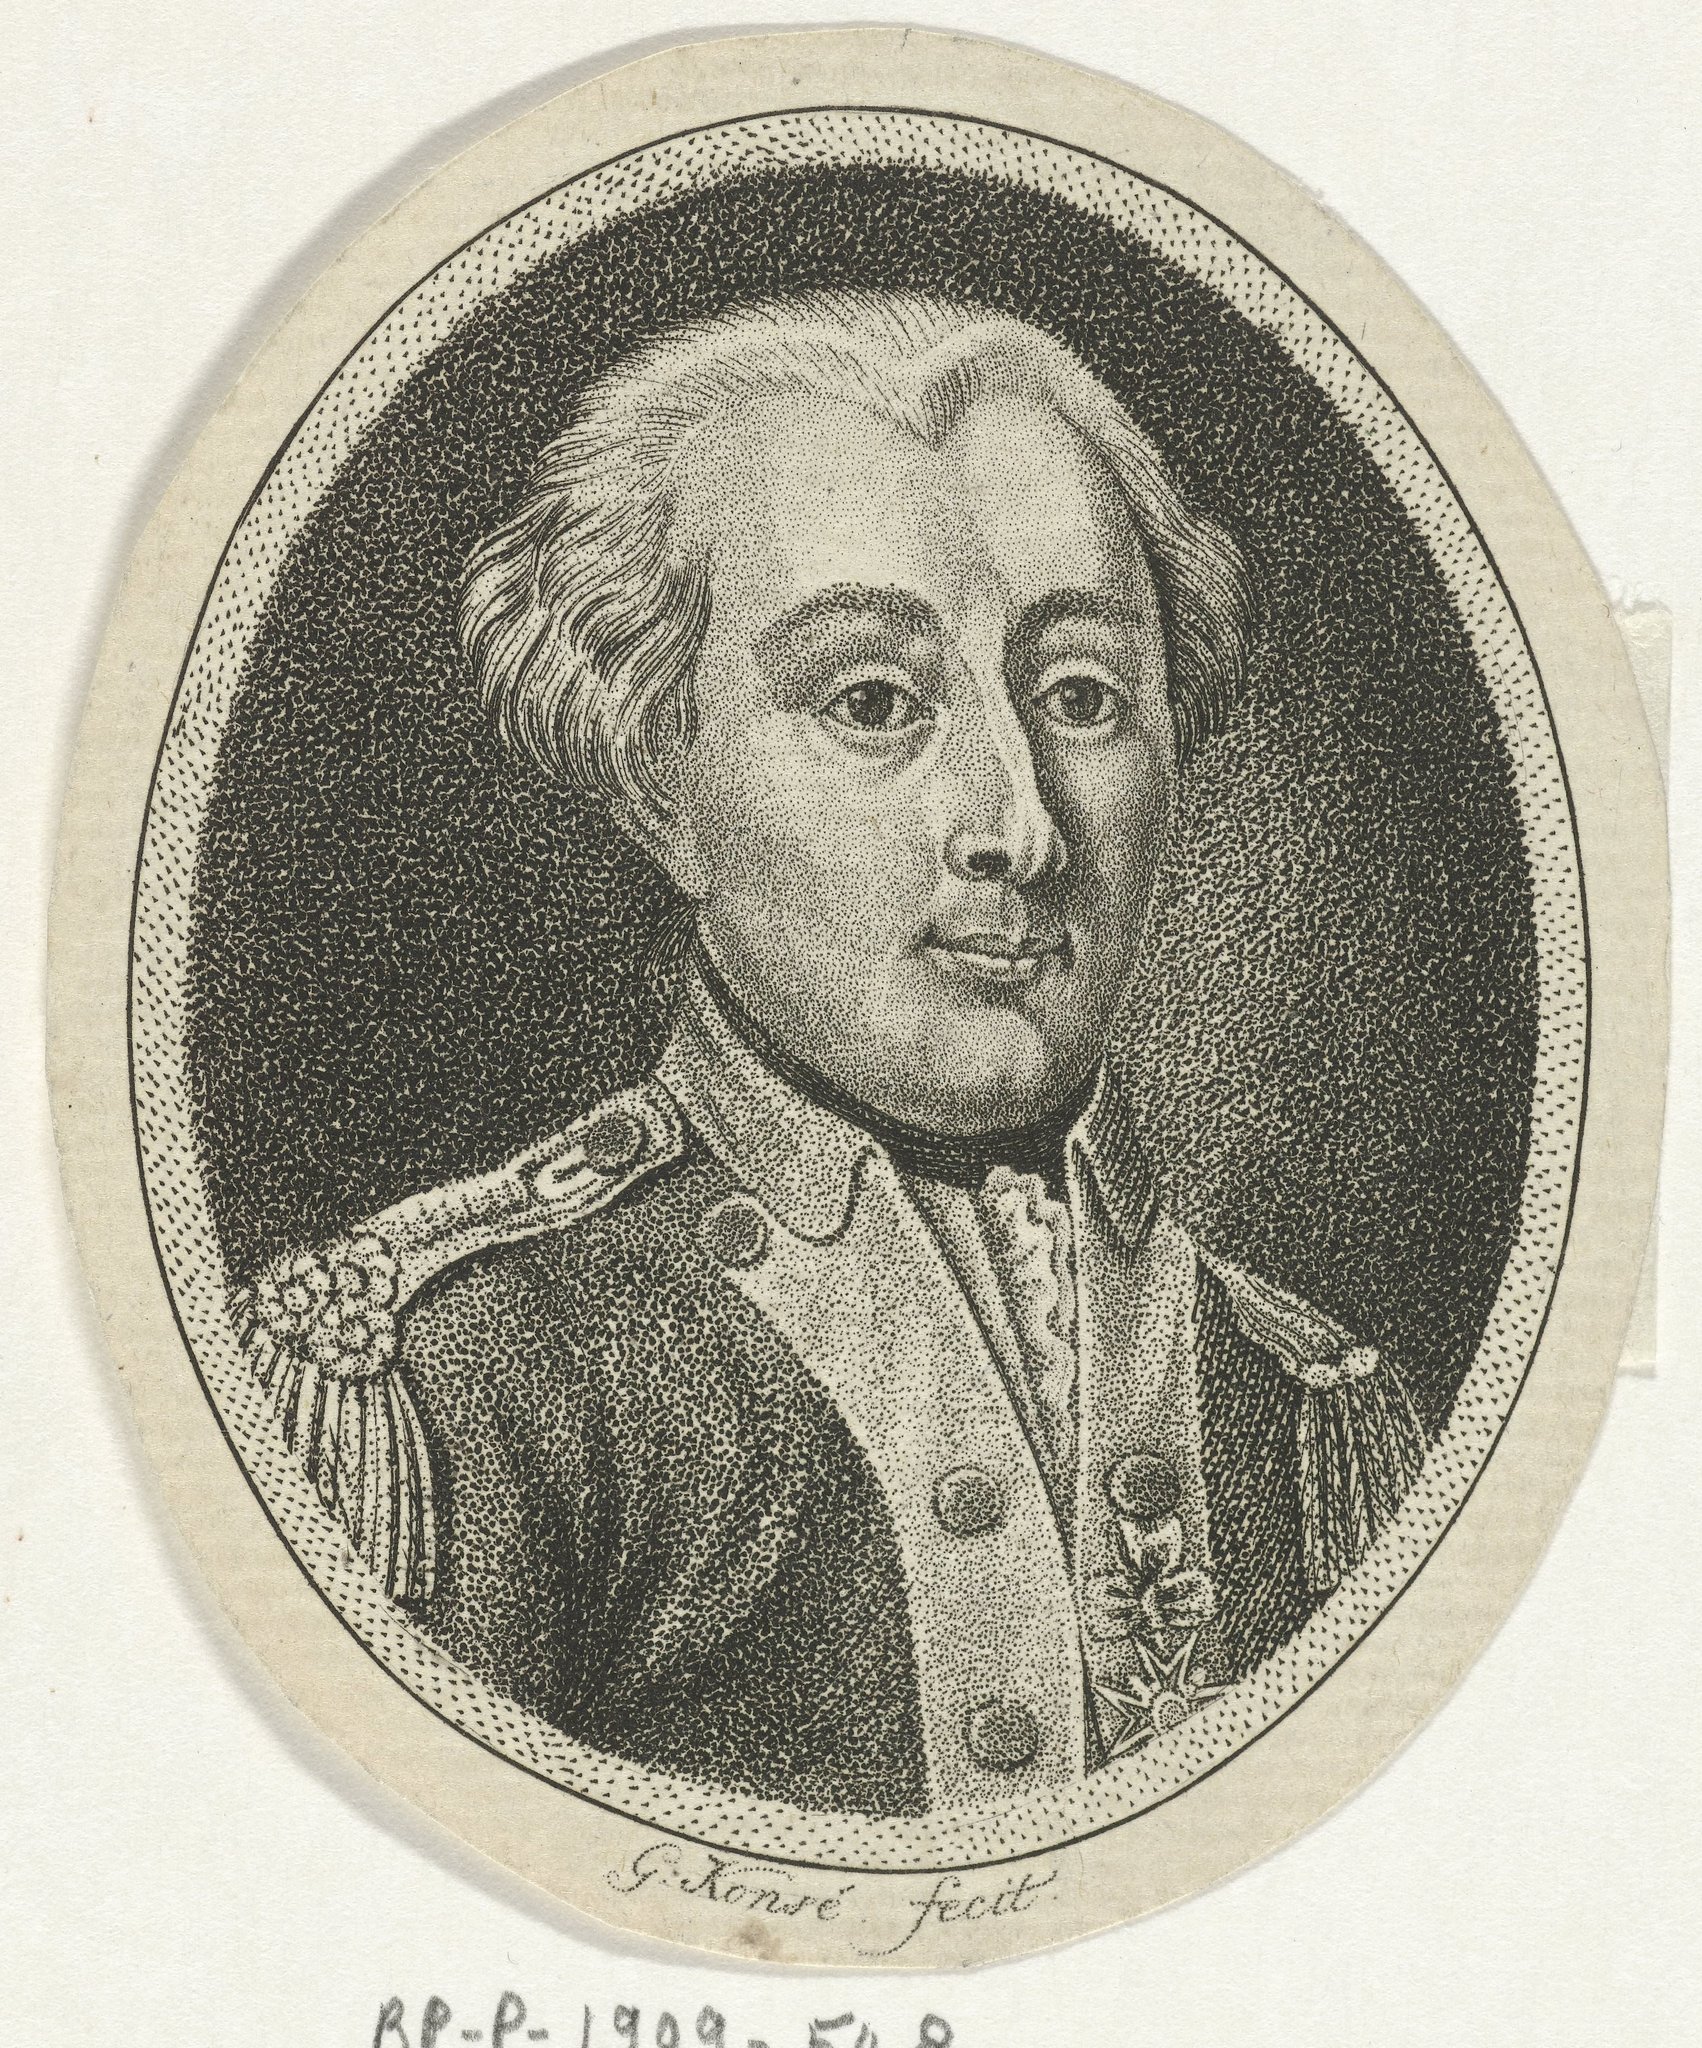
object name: print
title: Portret van Abraham Valentijn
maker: gerrit konsé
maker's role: print maker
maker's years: 1751-1826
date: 1761-1826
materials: paper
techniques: engraving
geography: amsterdam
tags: kapitein, abraham valentijn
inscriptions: collector's mark: Lugt 2228, inscription: ‘Valentijn’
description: Portretbuste van A. Valentijn, gevat in een ovaal. Valentijn was kapitein in 1787.